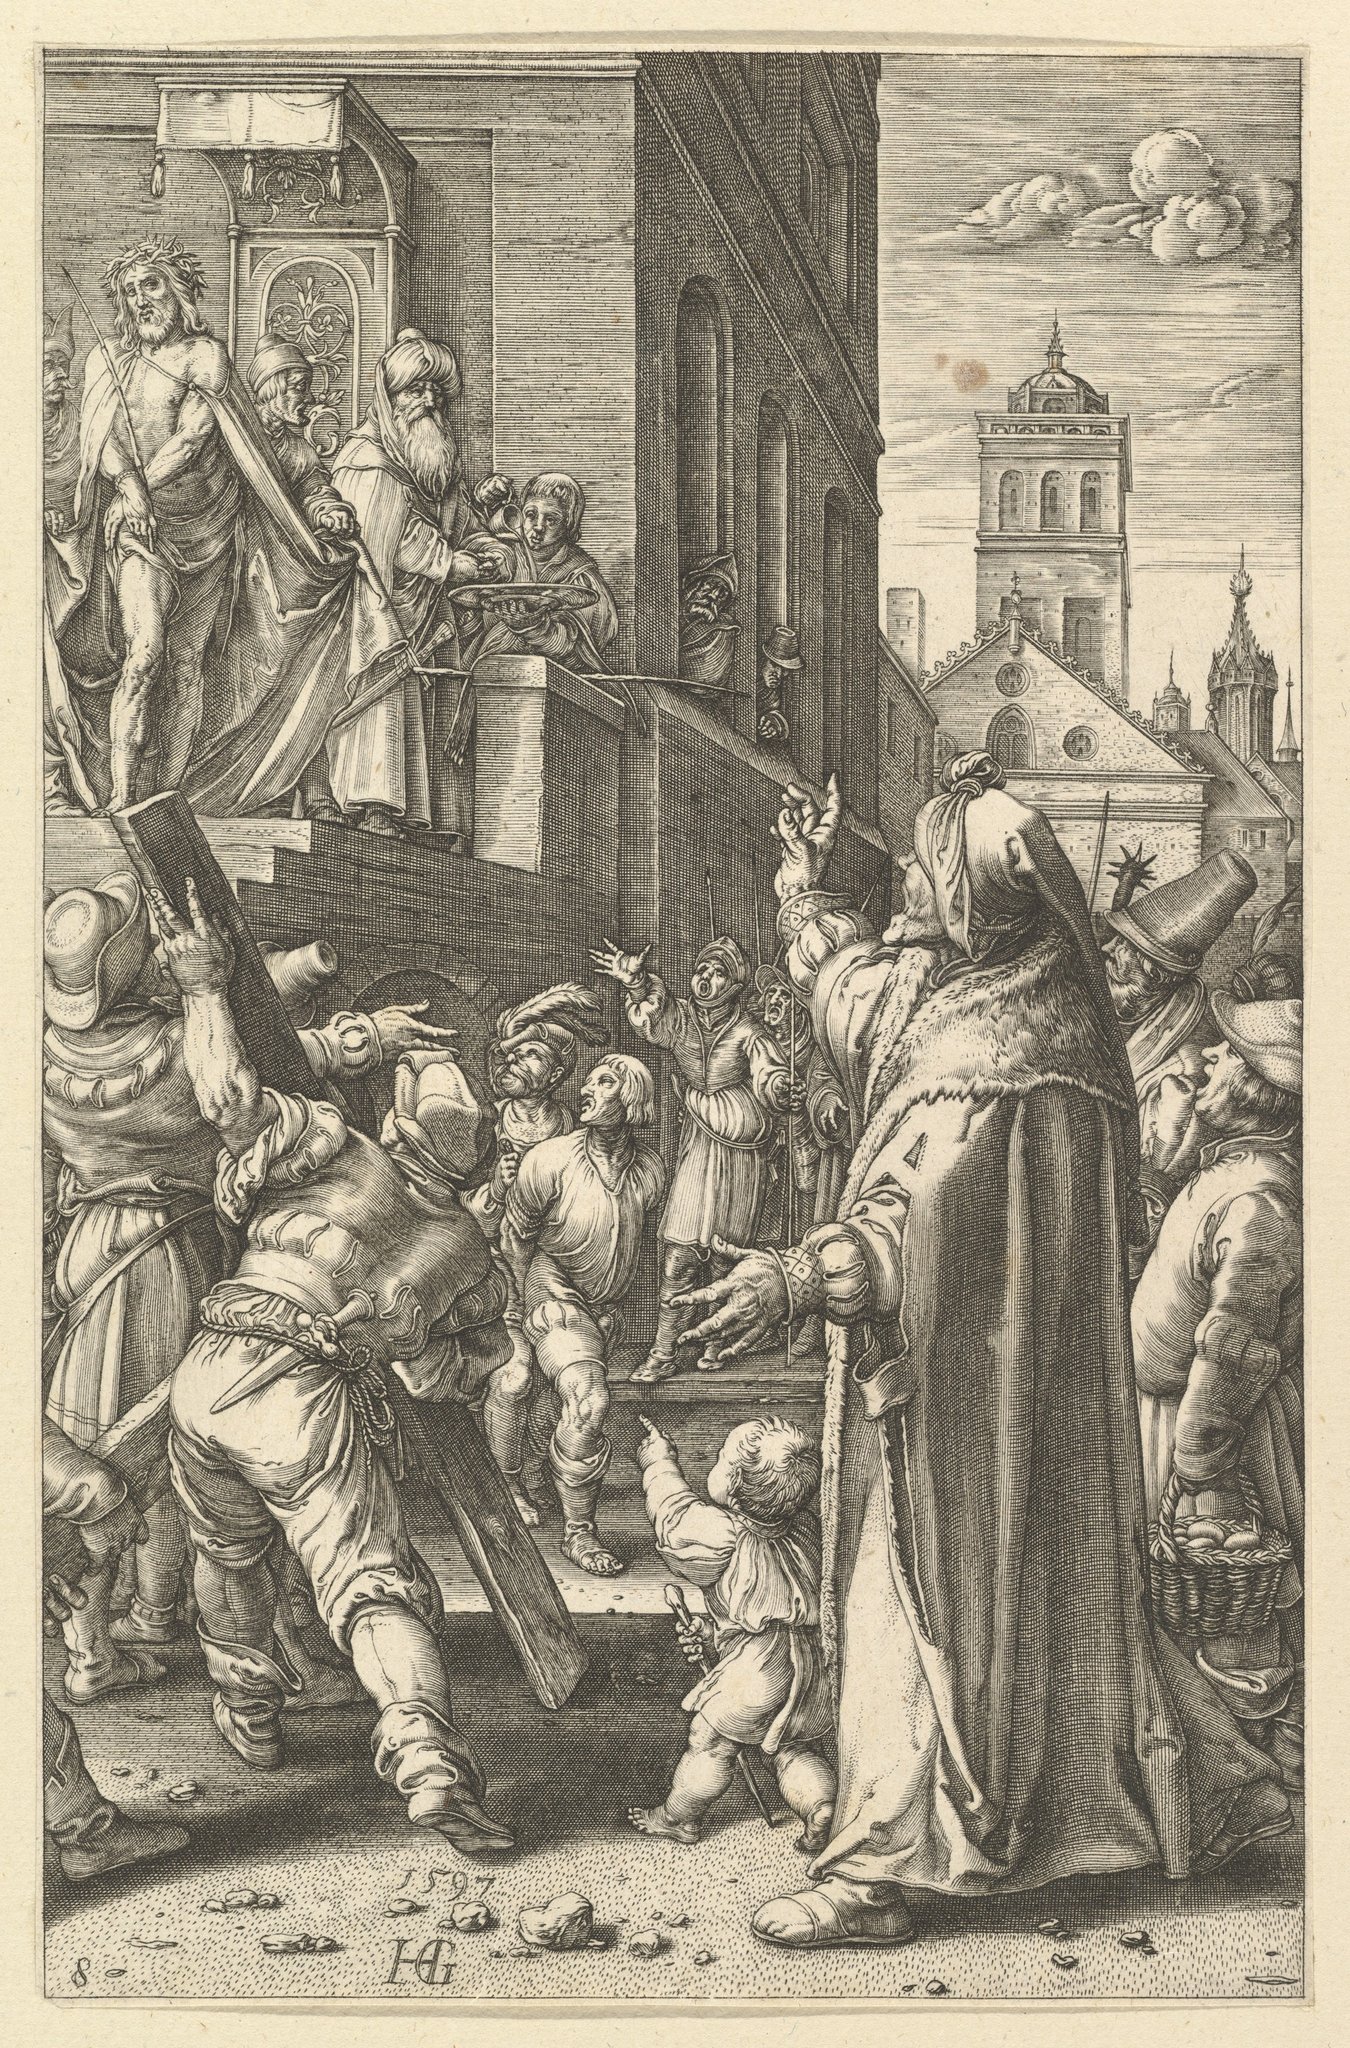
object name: print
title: Ecce Homo, from "The Passion of Christ"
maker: Anonymous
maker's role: artist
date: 1598-1617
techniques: engraving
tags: buildings,jesus,crowd